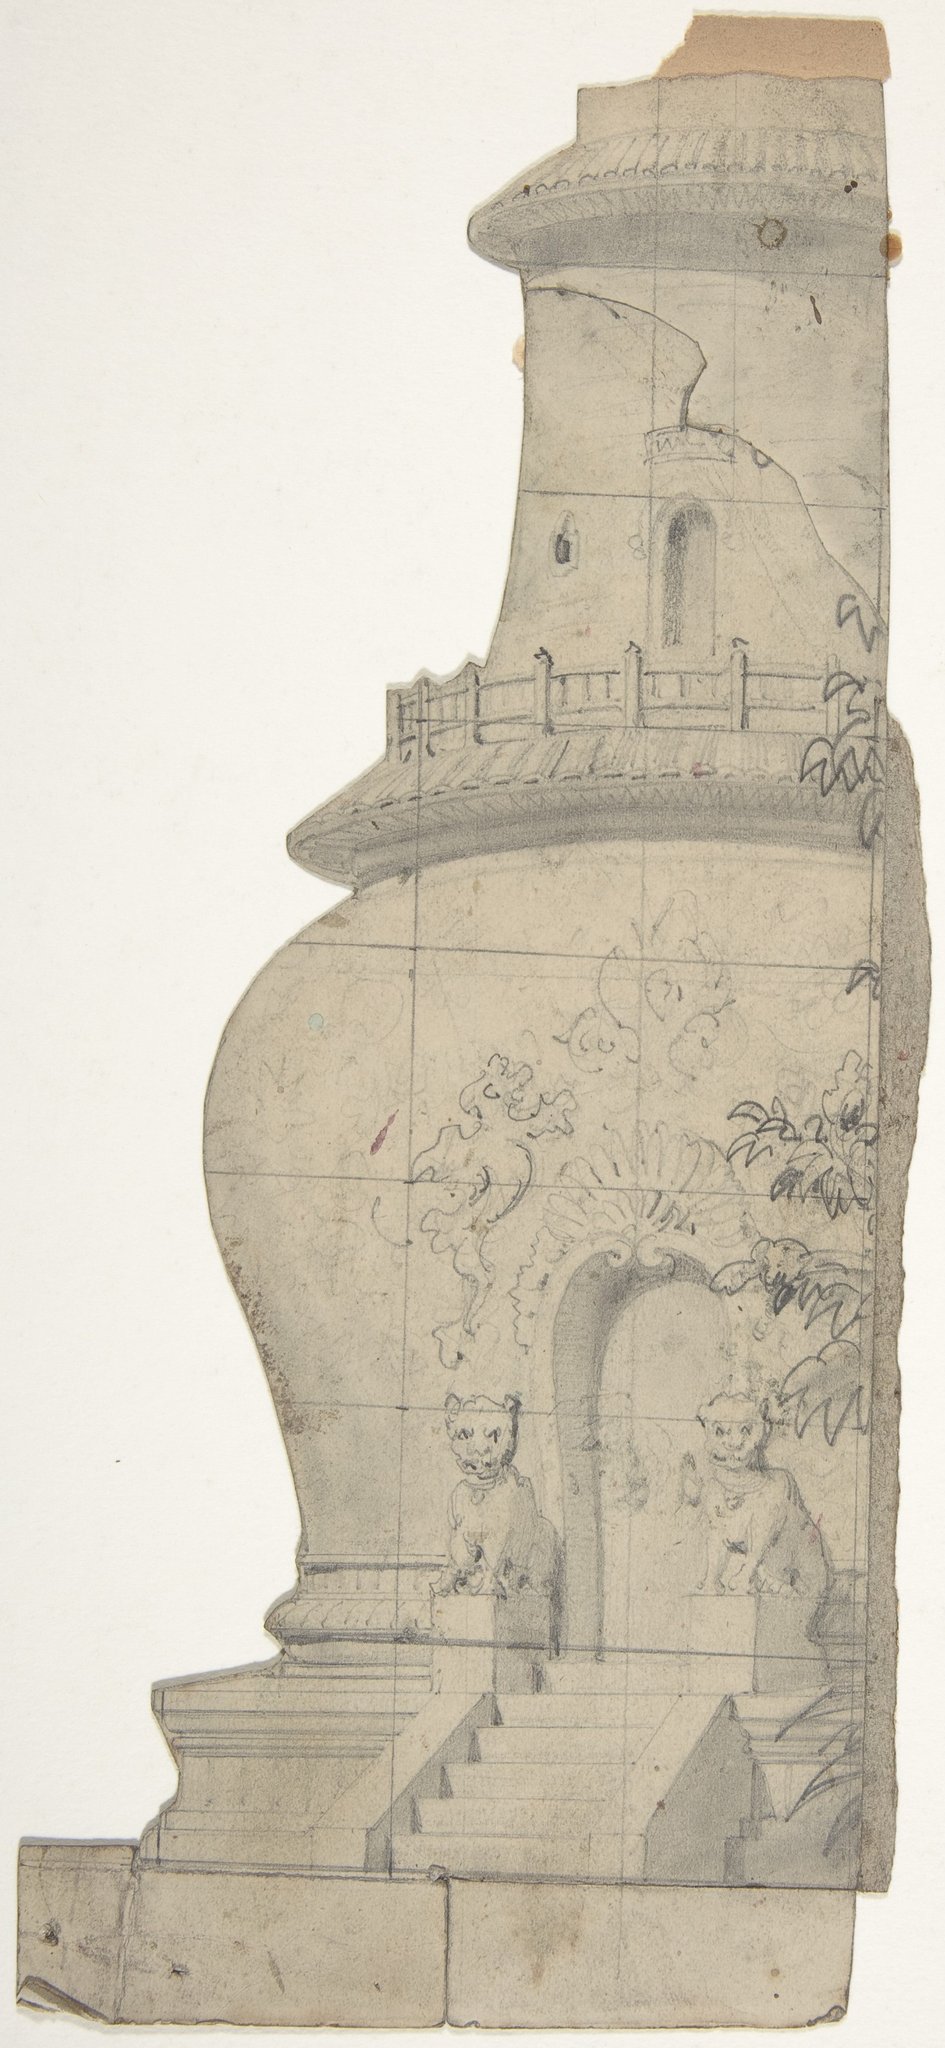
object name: drawing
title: Design for a Stage Set at the Opéra, Paris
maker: eugène cicéri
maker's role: artist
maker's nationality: french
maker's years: 1813-1890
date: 1830-1890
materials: graphite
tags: stage design